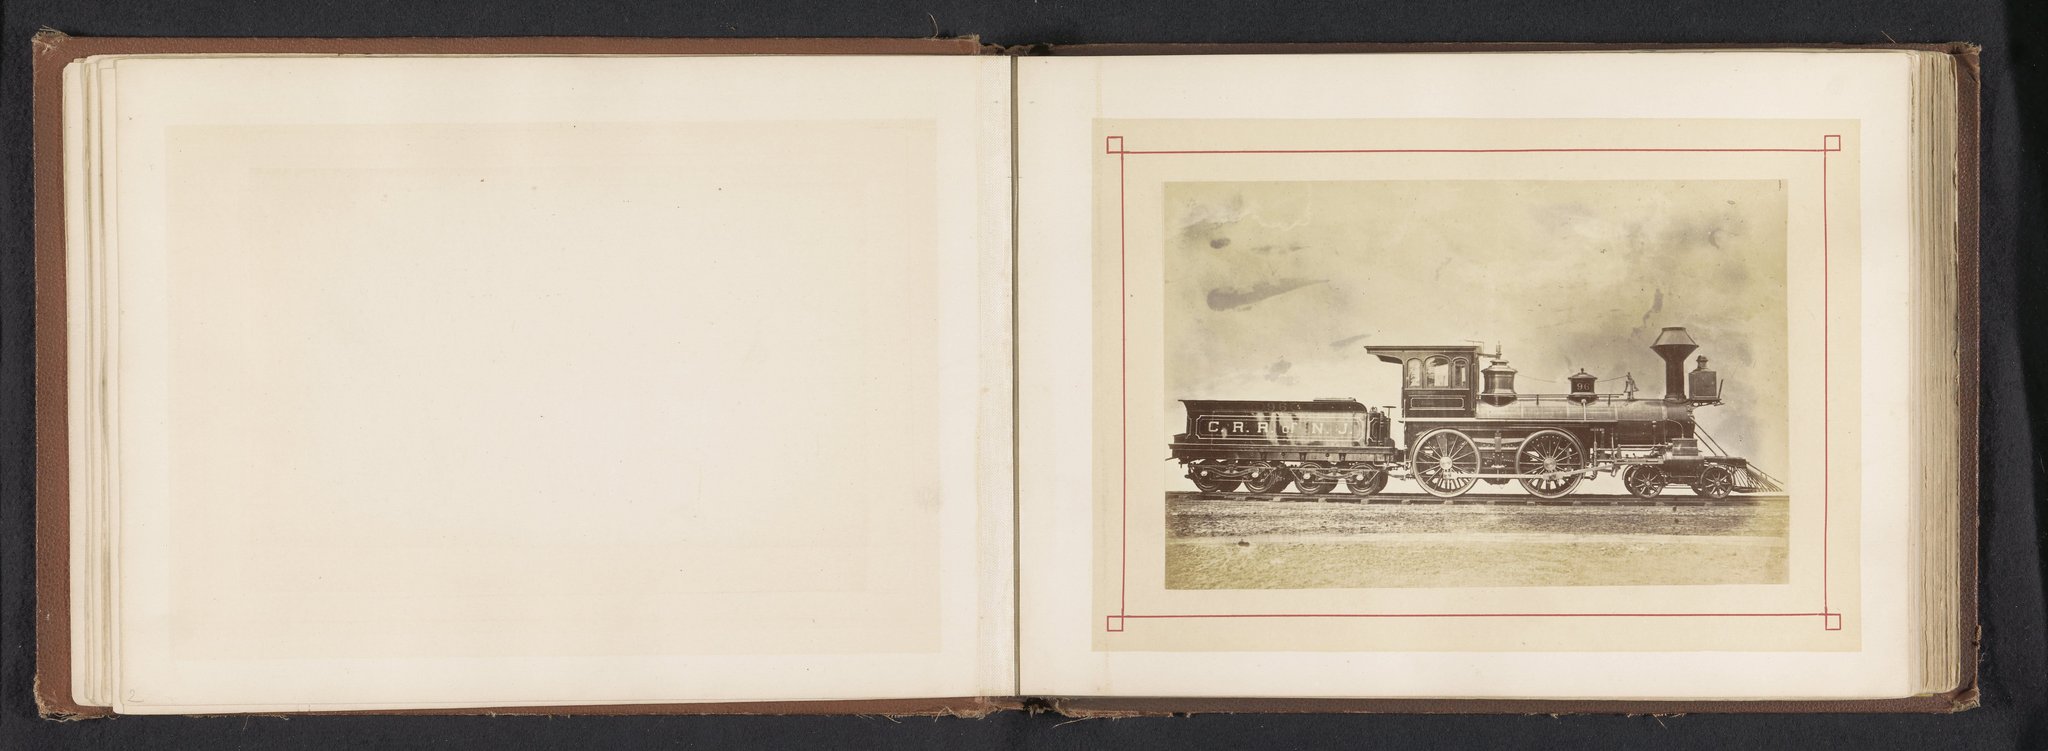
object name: photograph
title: Stoomlocomotief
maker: george gardner rockwood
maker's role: fotograaf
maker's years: 1832-1911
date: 1861-1871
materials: photographic support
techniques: albumen print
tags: steam locomotive